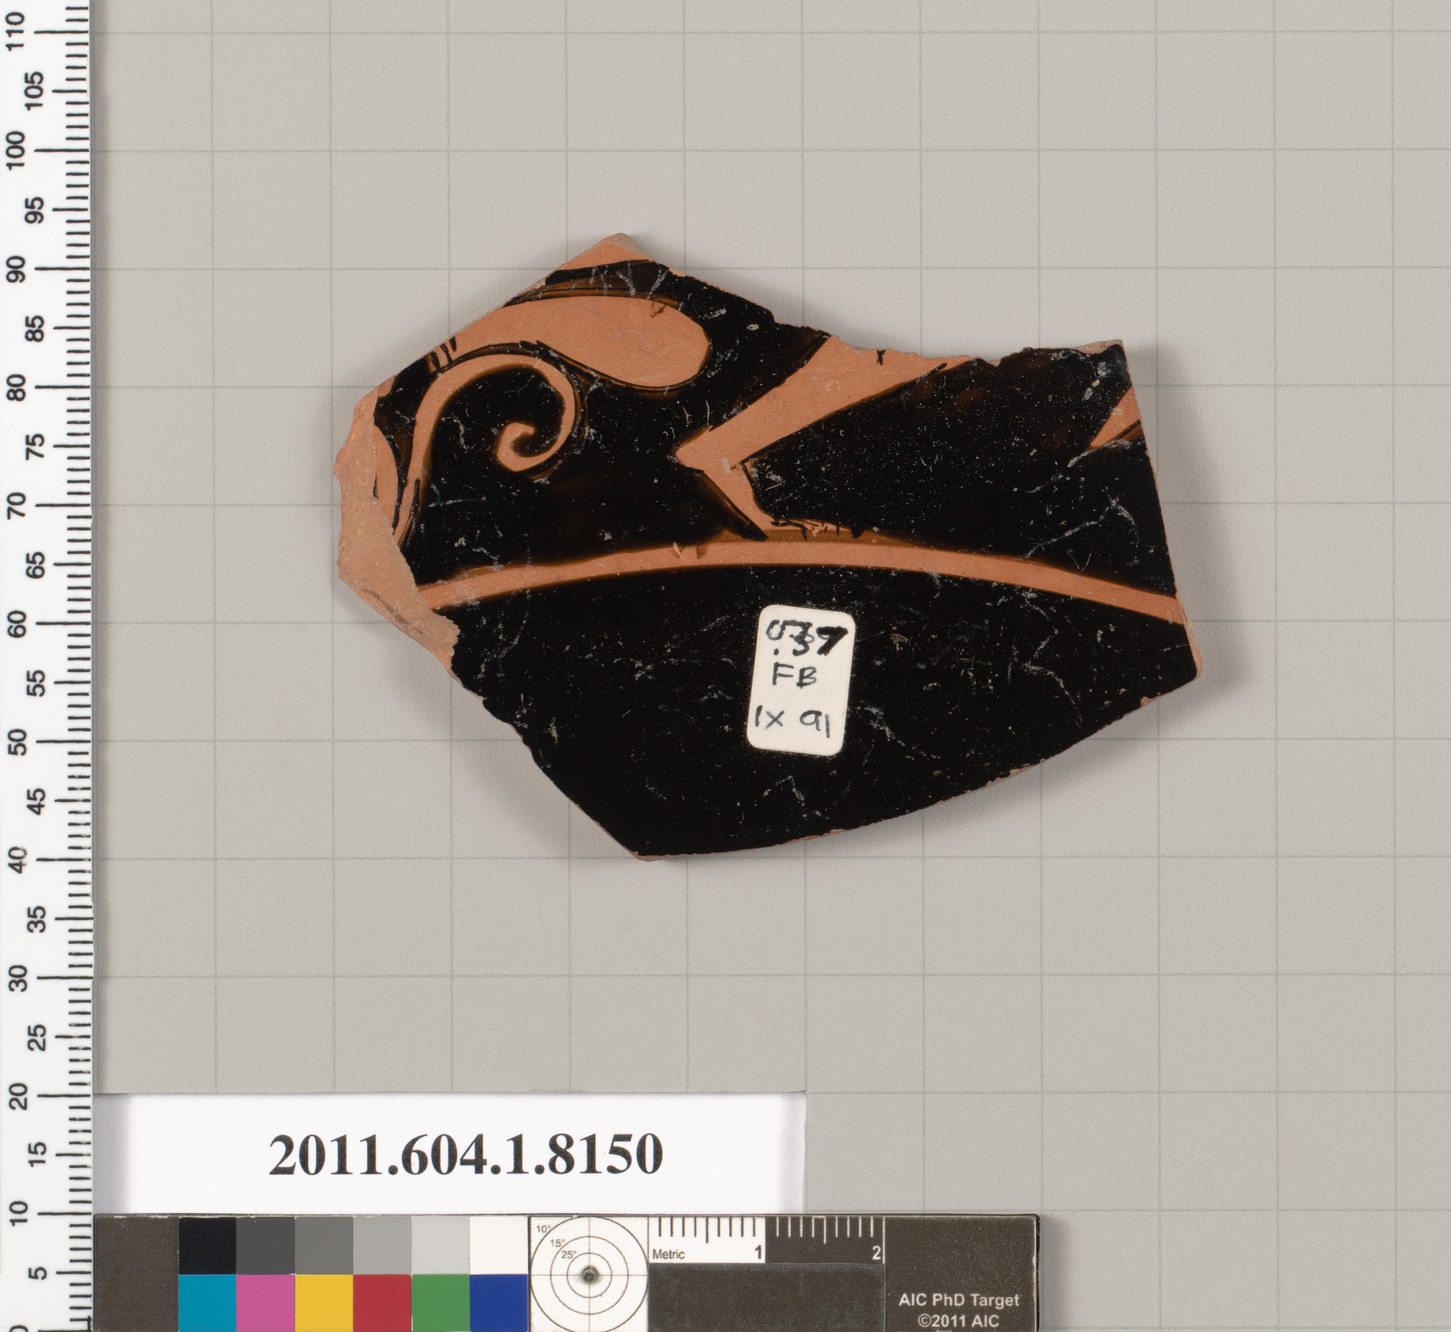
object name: kylix fragment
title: Terracotta fragment of a kylix (drinking cup)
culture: greek, attic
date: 520-500 BCE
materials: terracotta